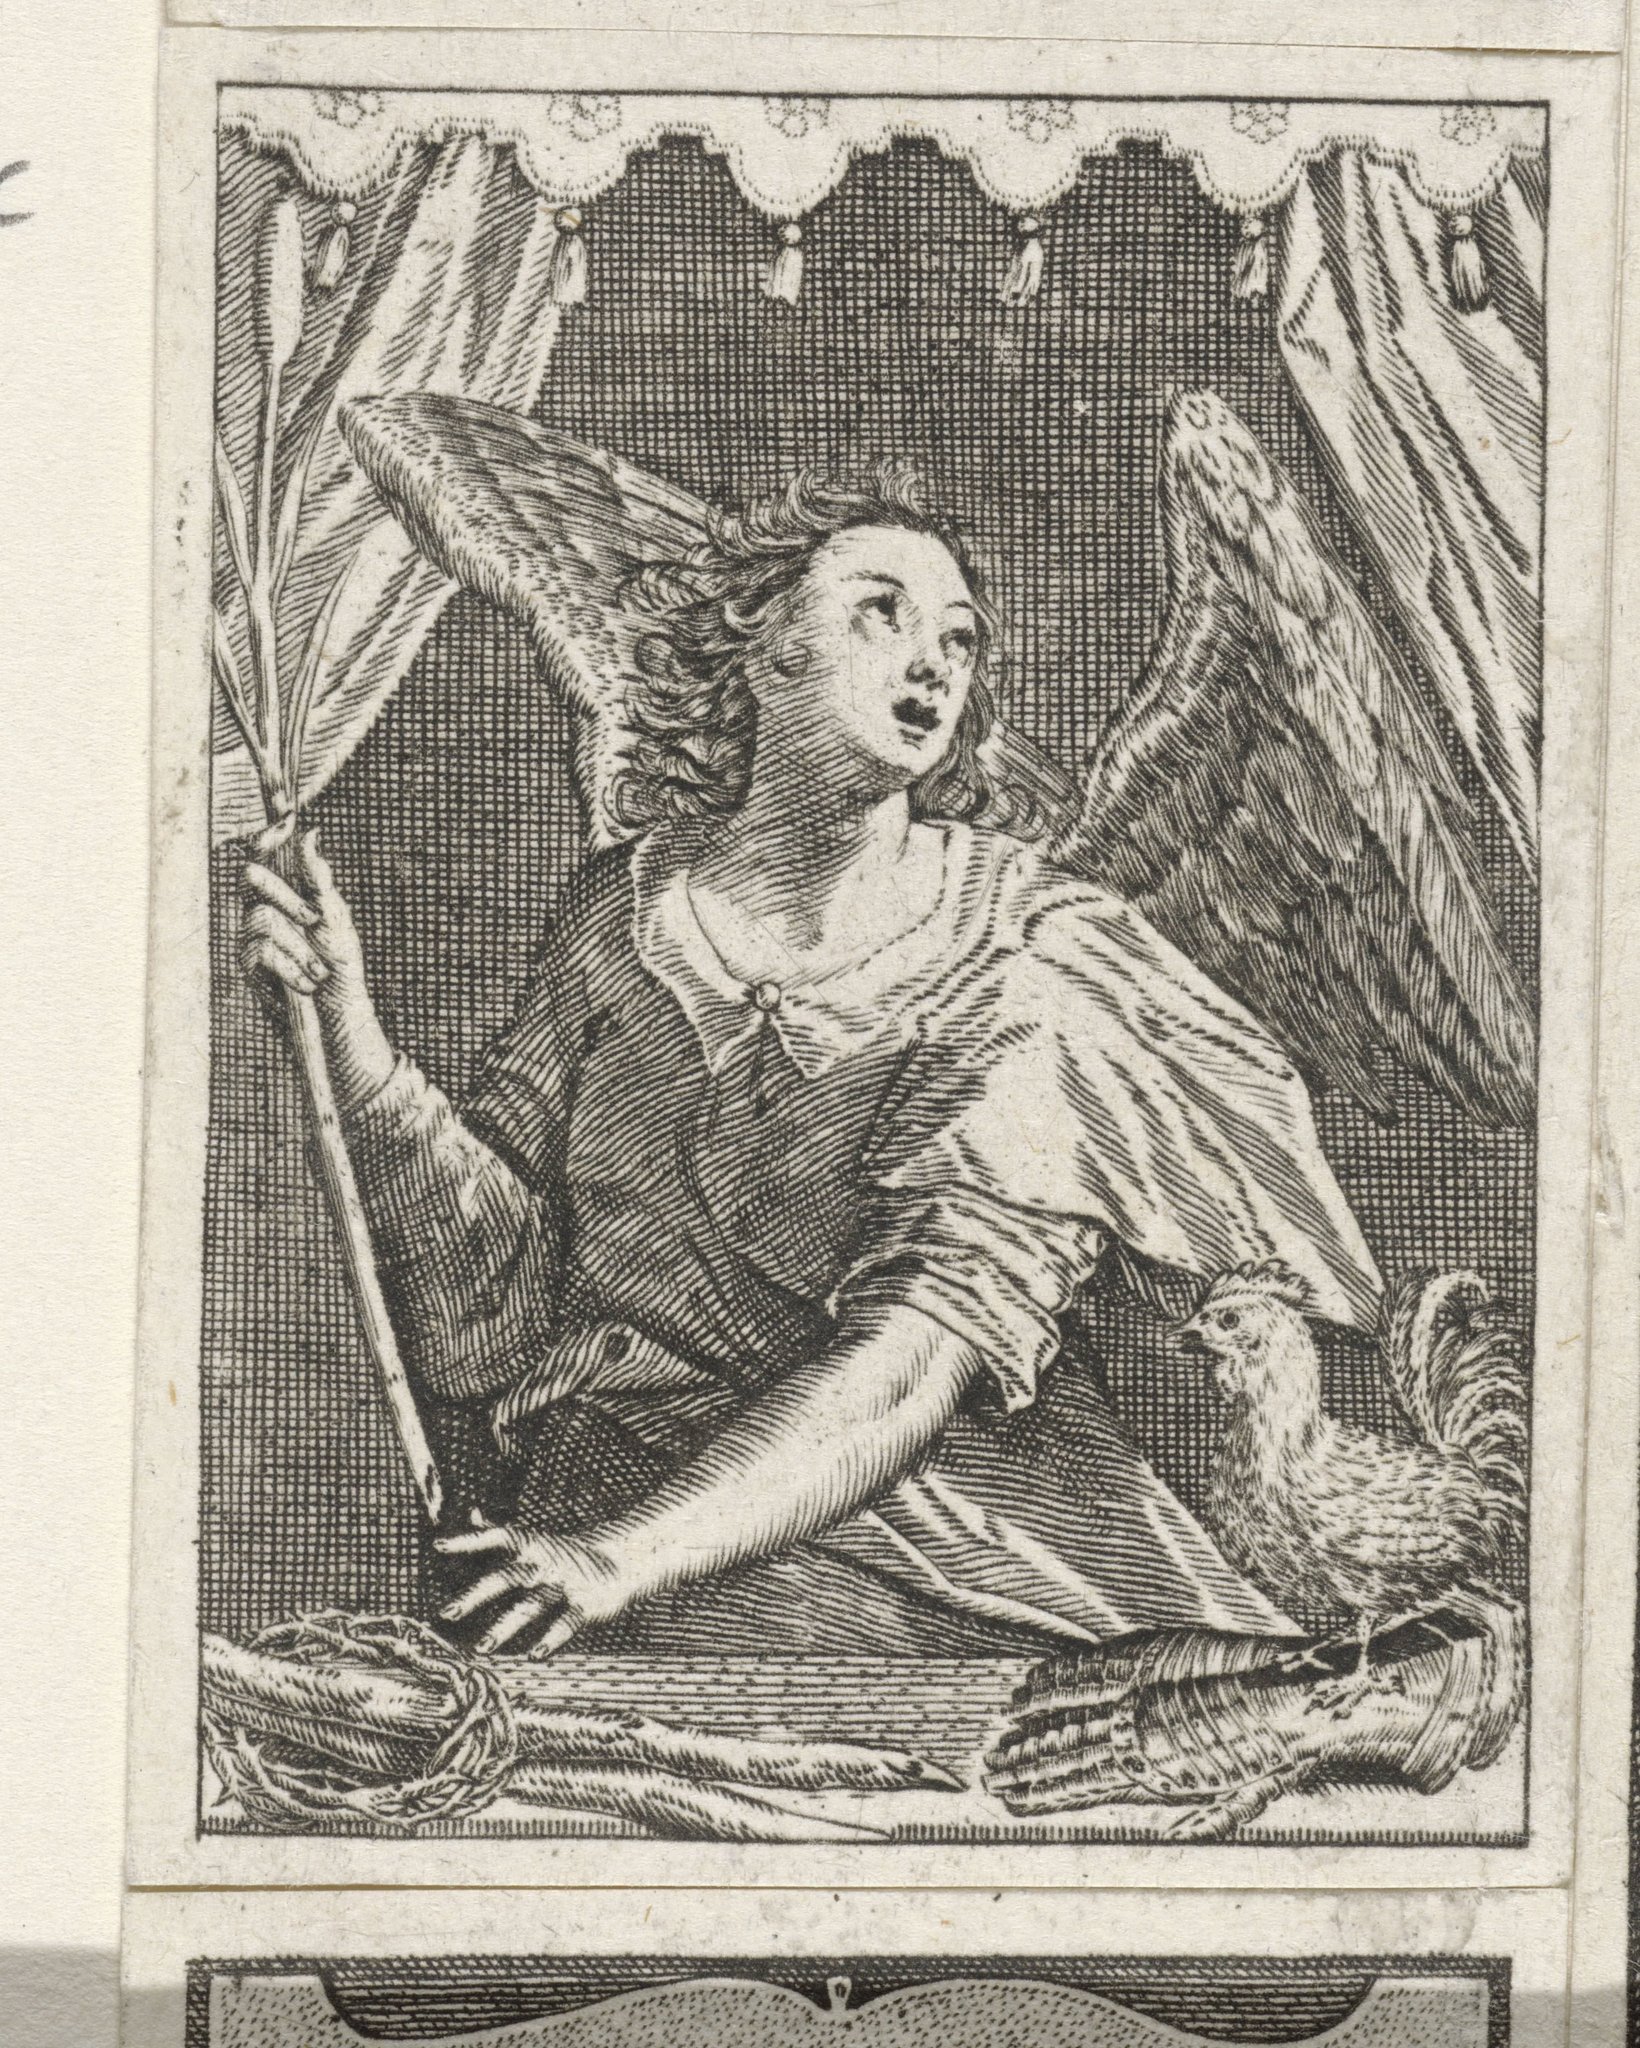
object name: print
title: Engel met de rietstengel, de haan en de doornenkroon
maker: johann sadeler (i)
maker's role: print maker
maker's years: 1550-1600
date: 1580-1600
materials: paper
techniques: engraving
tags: single instruments of the passion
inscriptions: collector's mark: Lugt 240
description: Passiewerktuigen zijn kopie in spiegelbeeld.